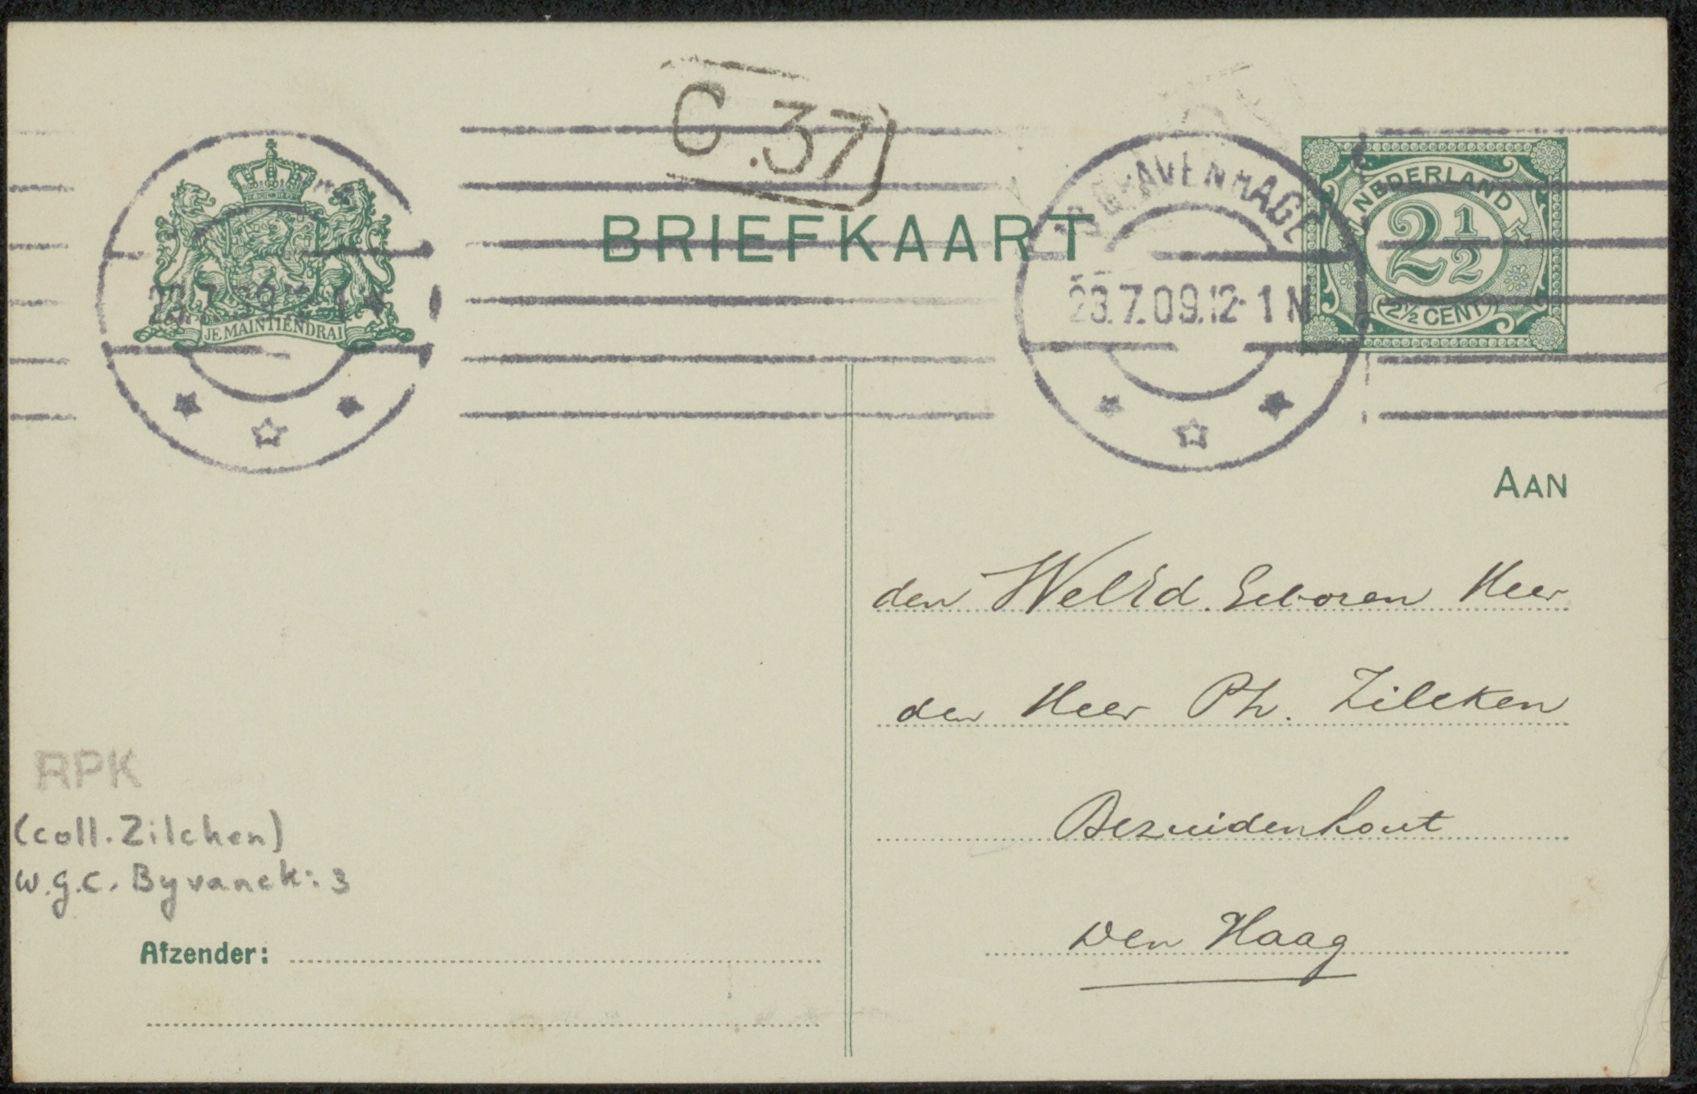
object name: postcard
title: Briefkaart aan Philip Zilcken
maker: willem byvanck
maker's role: bibliothecaris, schrijver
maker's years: 1848-1925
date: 1909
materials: cardboard, ink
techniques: pen, writing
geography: the hague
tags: painter, draughtsman, philip zilcken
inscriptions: collector's mark: ‘RPK’